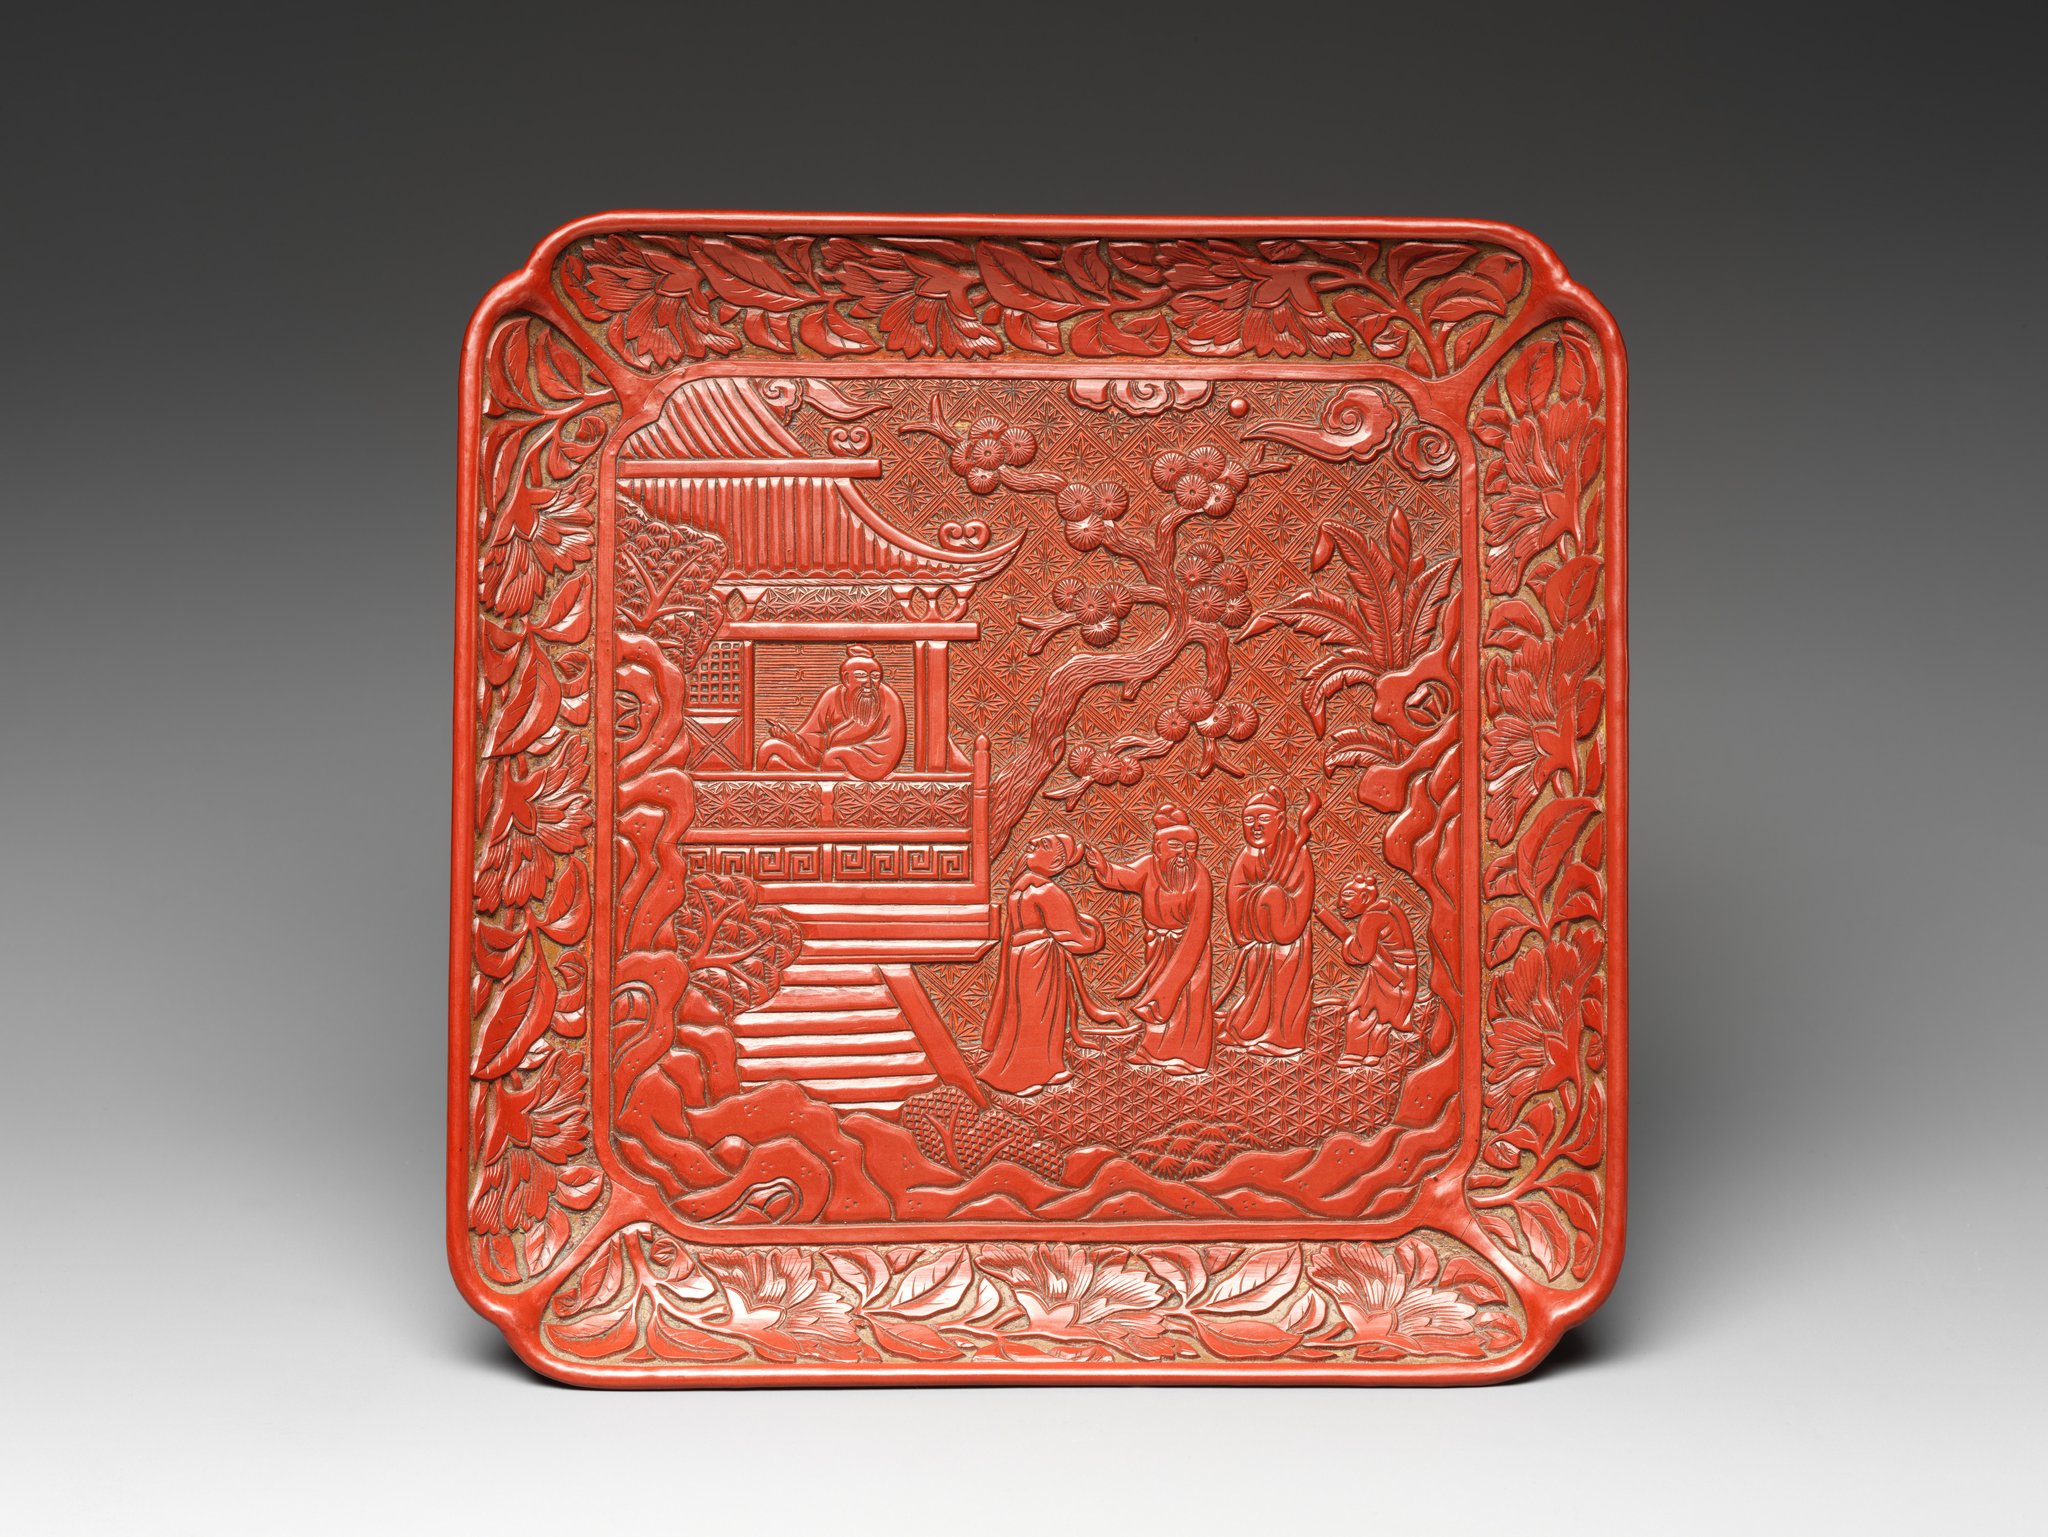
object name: dish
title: Square dish with figures in a garden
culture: chinese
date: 1501-1600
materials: lacquer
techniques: carving